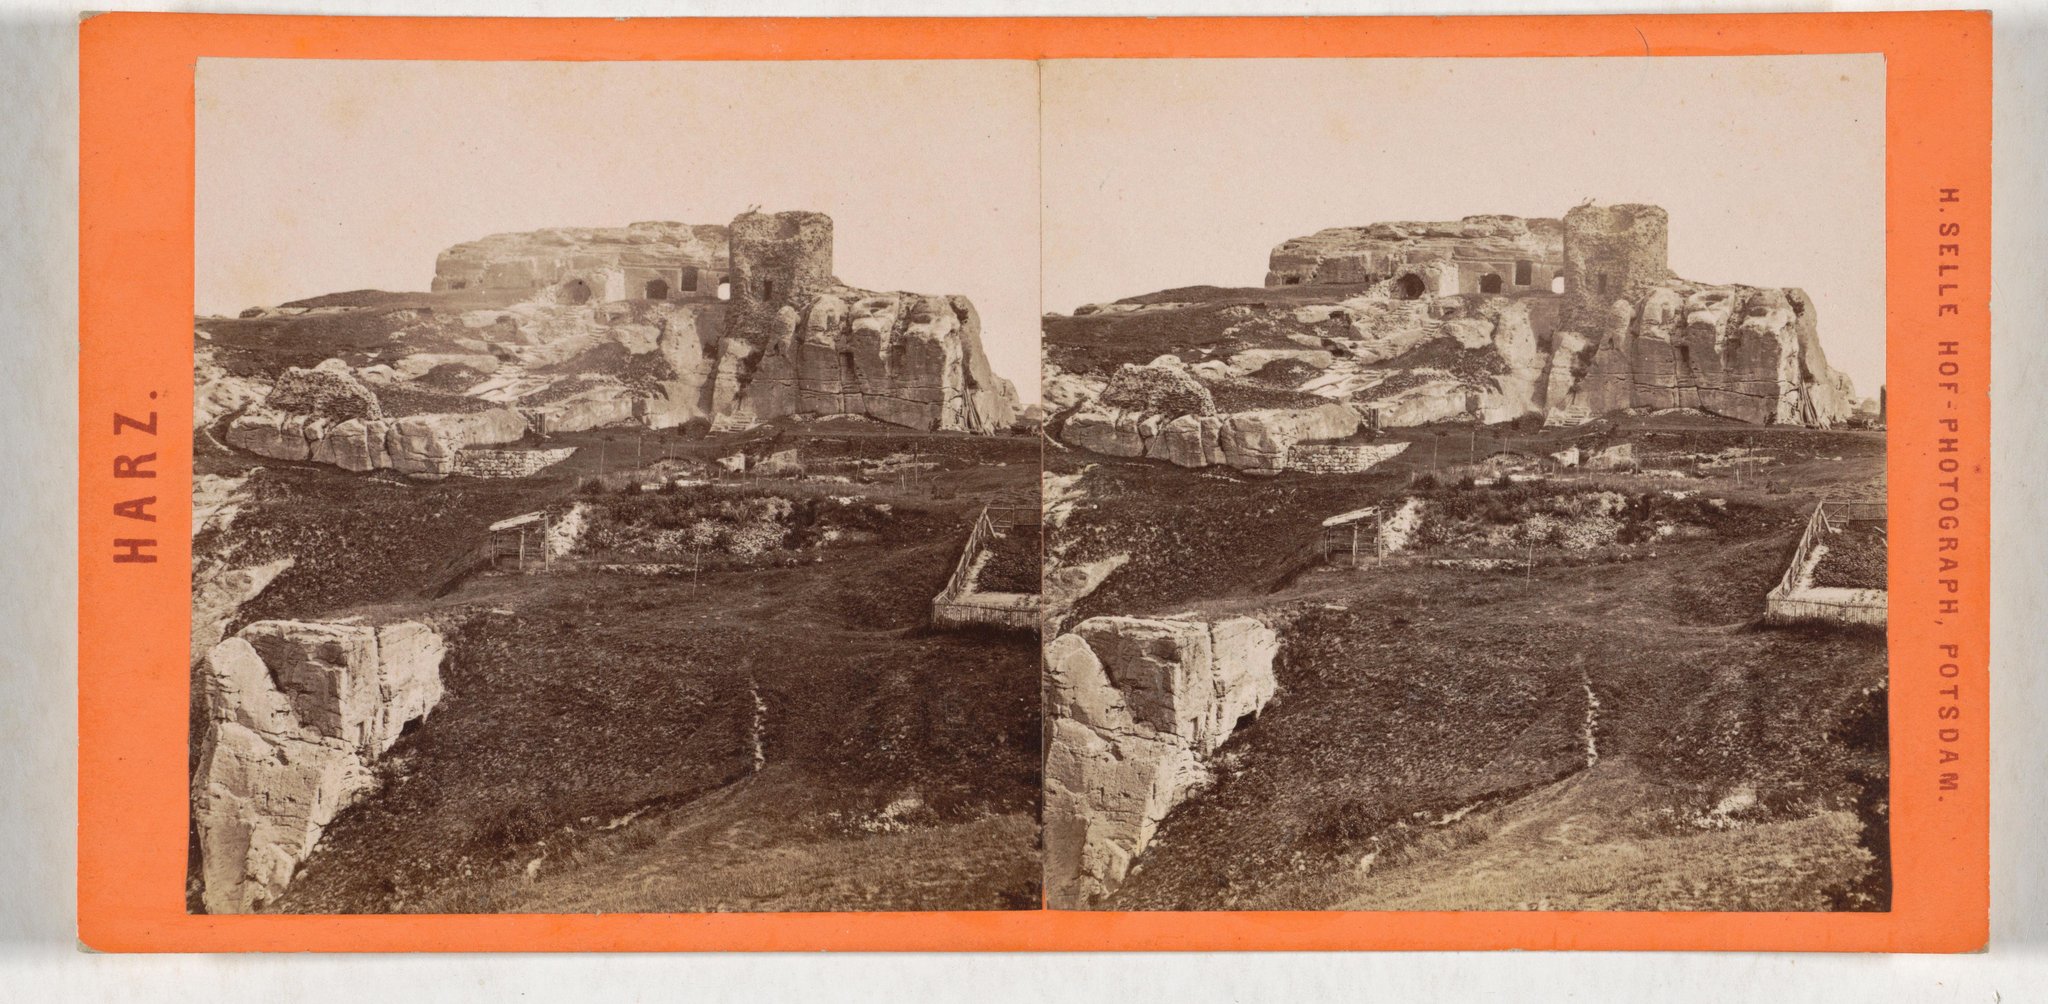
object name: stereograph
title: Der Regenstein bei Blankenburg, von Süden gesehen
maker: hermann selle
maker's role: fotograaf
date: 1866-1870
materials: cardboard, paper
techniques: albumen print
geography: blankenburg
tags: castle, ruin of a dwelling, house, castle, etc.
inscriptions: inscription: ‘Hof-Photograph. Potsdam.’, number: ‘No. 21.’, inscription: ‘Nordwärts von Blankenburg (...) Vorland viel be-/ sucht. (W. Riehl)’